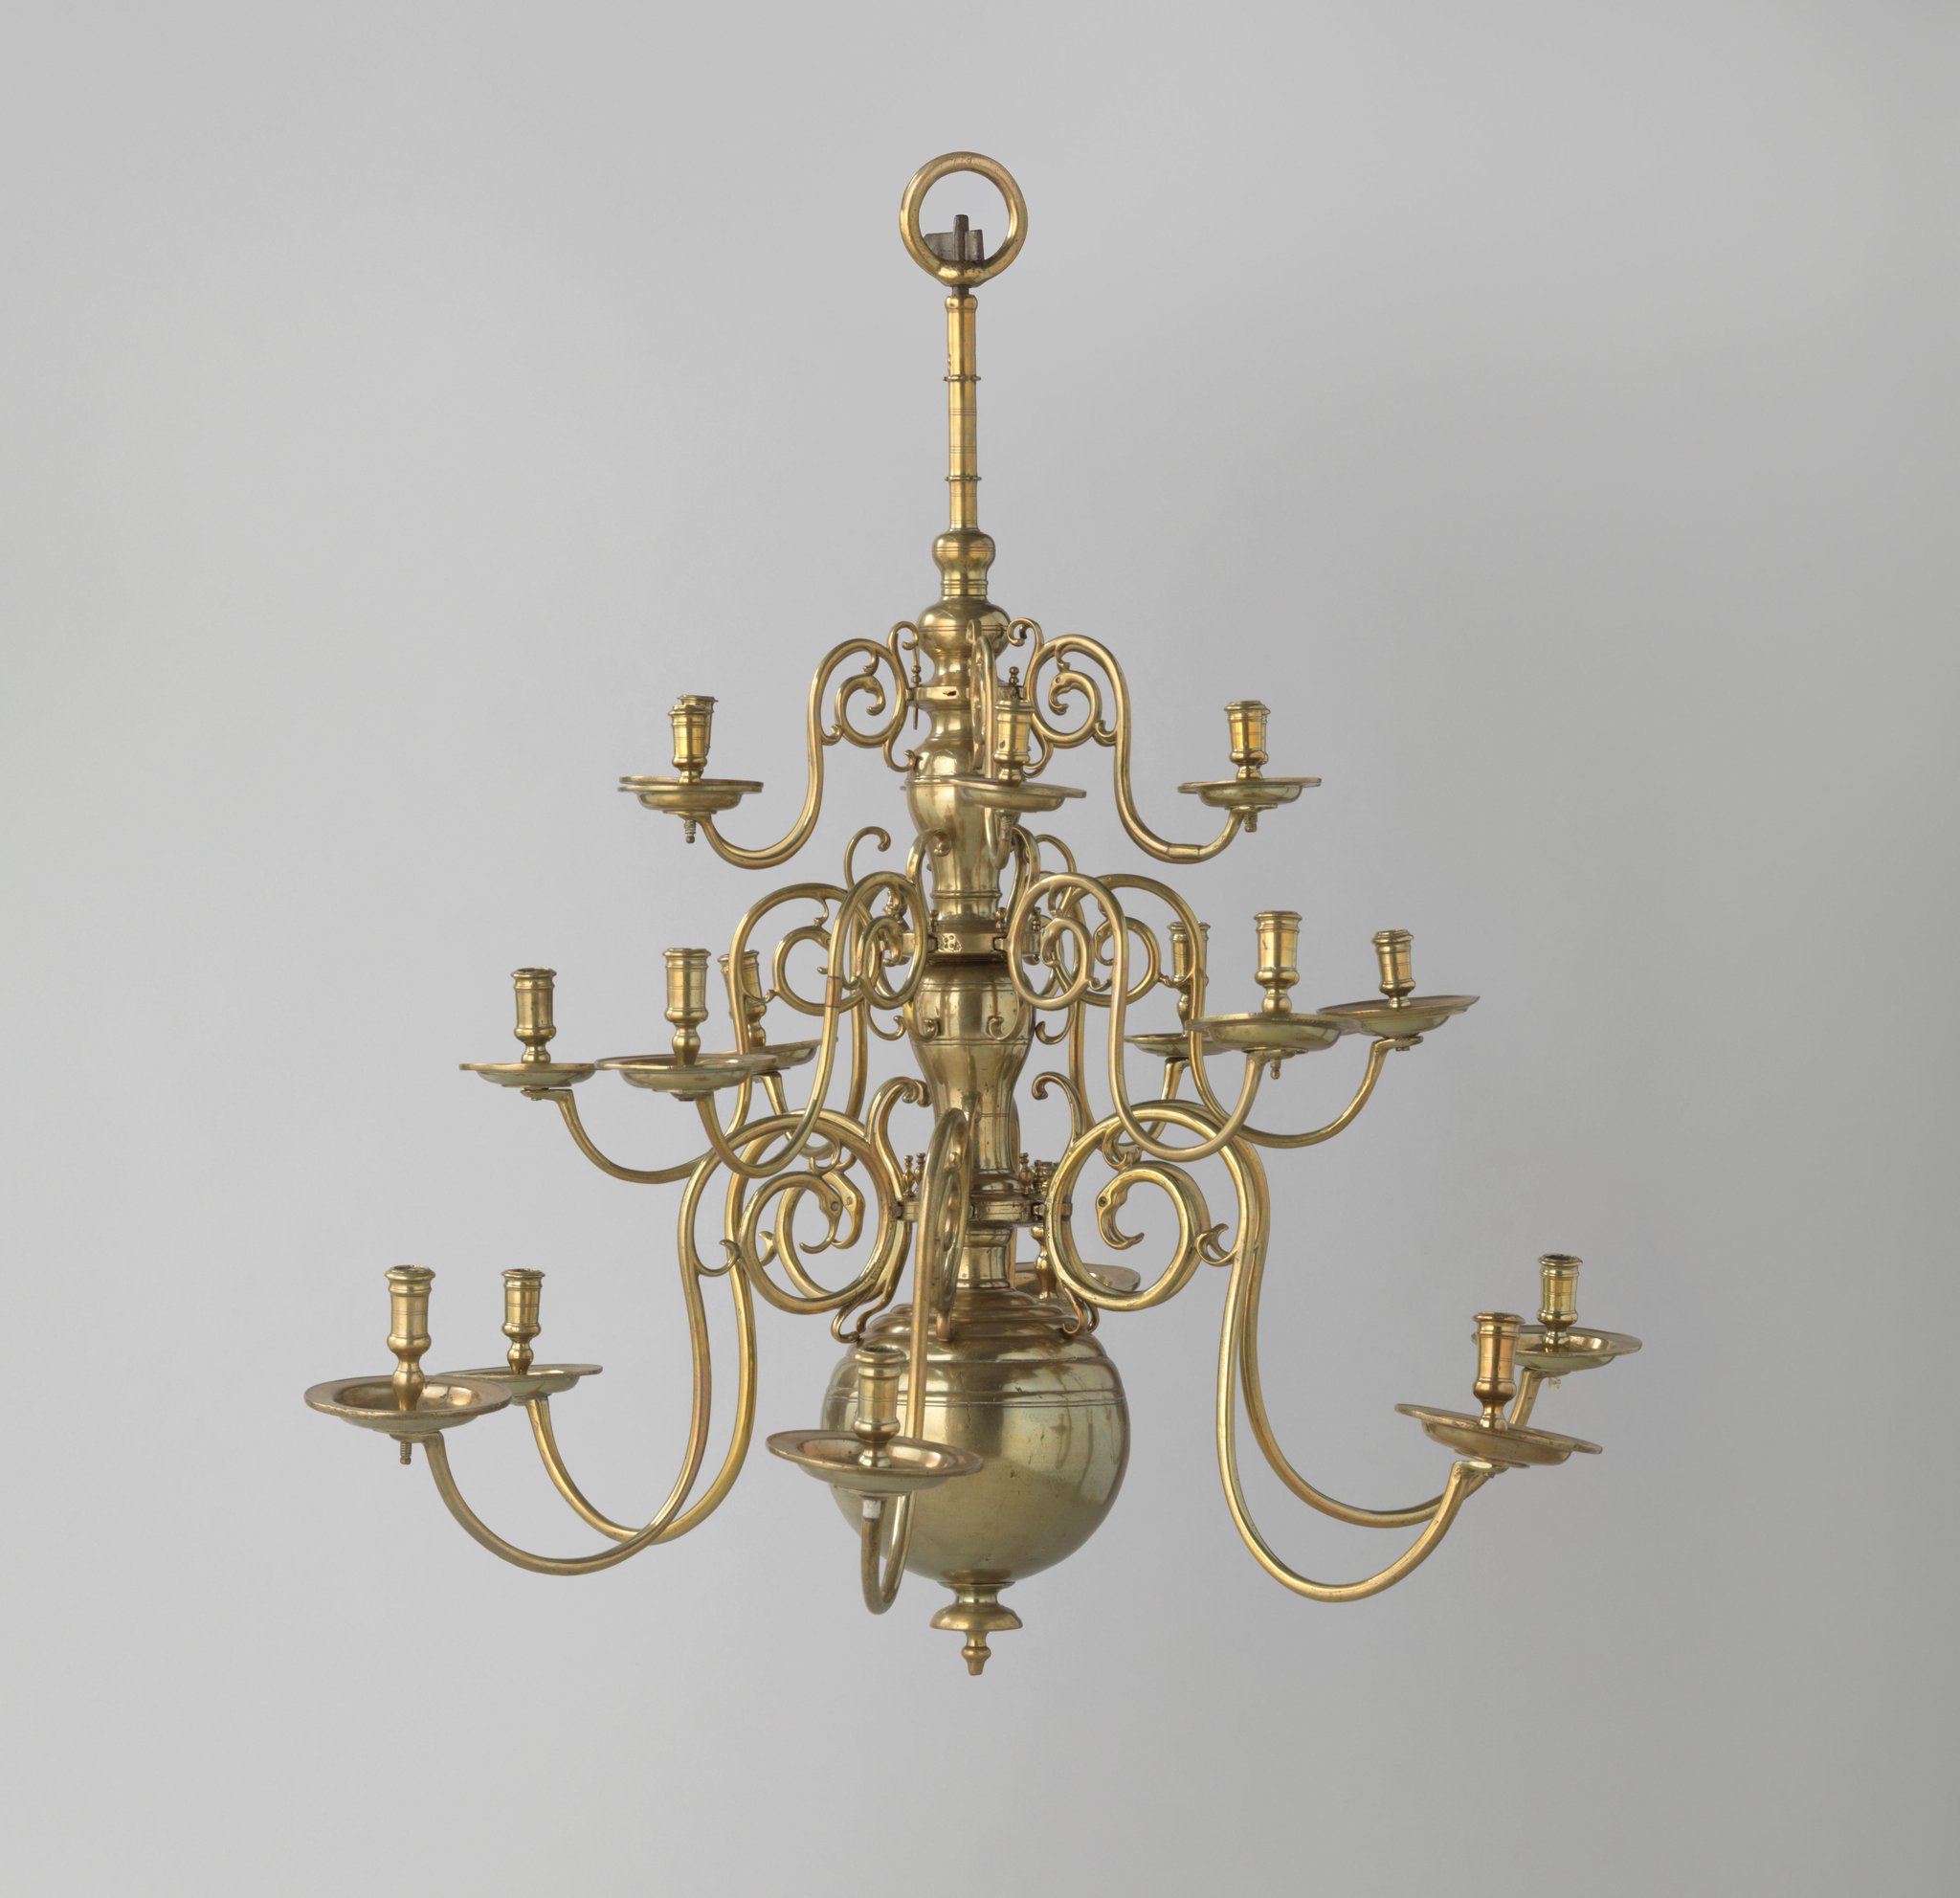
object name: chandelier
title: Arm met kaarsenhouder van kaarsenkroon van drie hoogten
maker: Anonymous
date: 1675-1725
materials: brass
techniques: casting, screwed, turning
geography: southern netherlands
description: Kaarsenarm behorende bij een messing kaarsenkroon van drie hoogten. De S-vormige arm heeft een krul en gaat naar buiten toe over in het platte verdikking met een schroefgat. Daarin is de kaarsenhouder met de vetvanger vastgezet. De vetvanger is aan de onderzijde geribd geprofileerd rond de opening en heeft verder twee maal twee gegroefde ringen. De cylindrische kaarsenhouder, die een geprofileerde uitstekende rand, twee gegroefde ringen en een verdikking onderaan heeft, gaat over in een baluster met onderaan het eind met schroefdraad en een knopje, waarin het centergat te zien is. Dit is de zesde arm van de bovenste standring, ongenummerd. De pin, om de arm aan de standring te bevestigen, heeft bovenop een ronde knop.